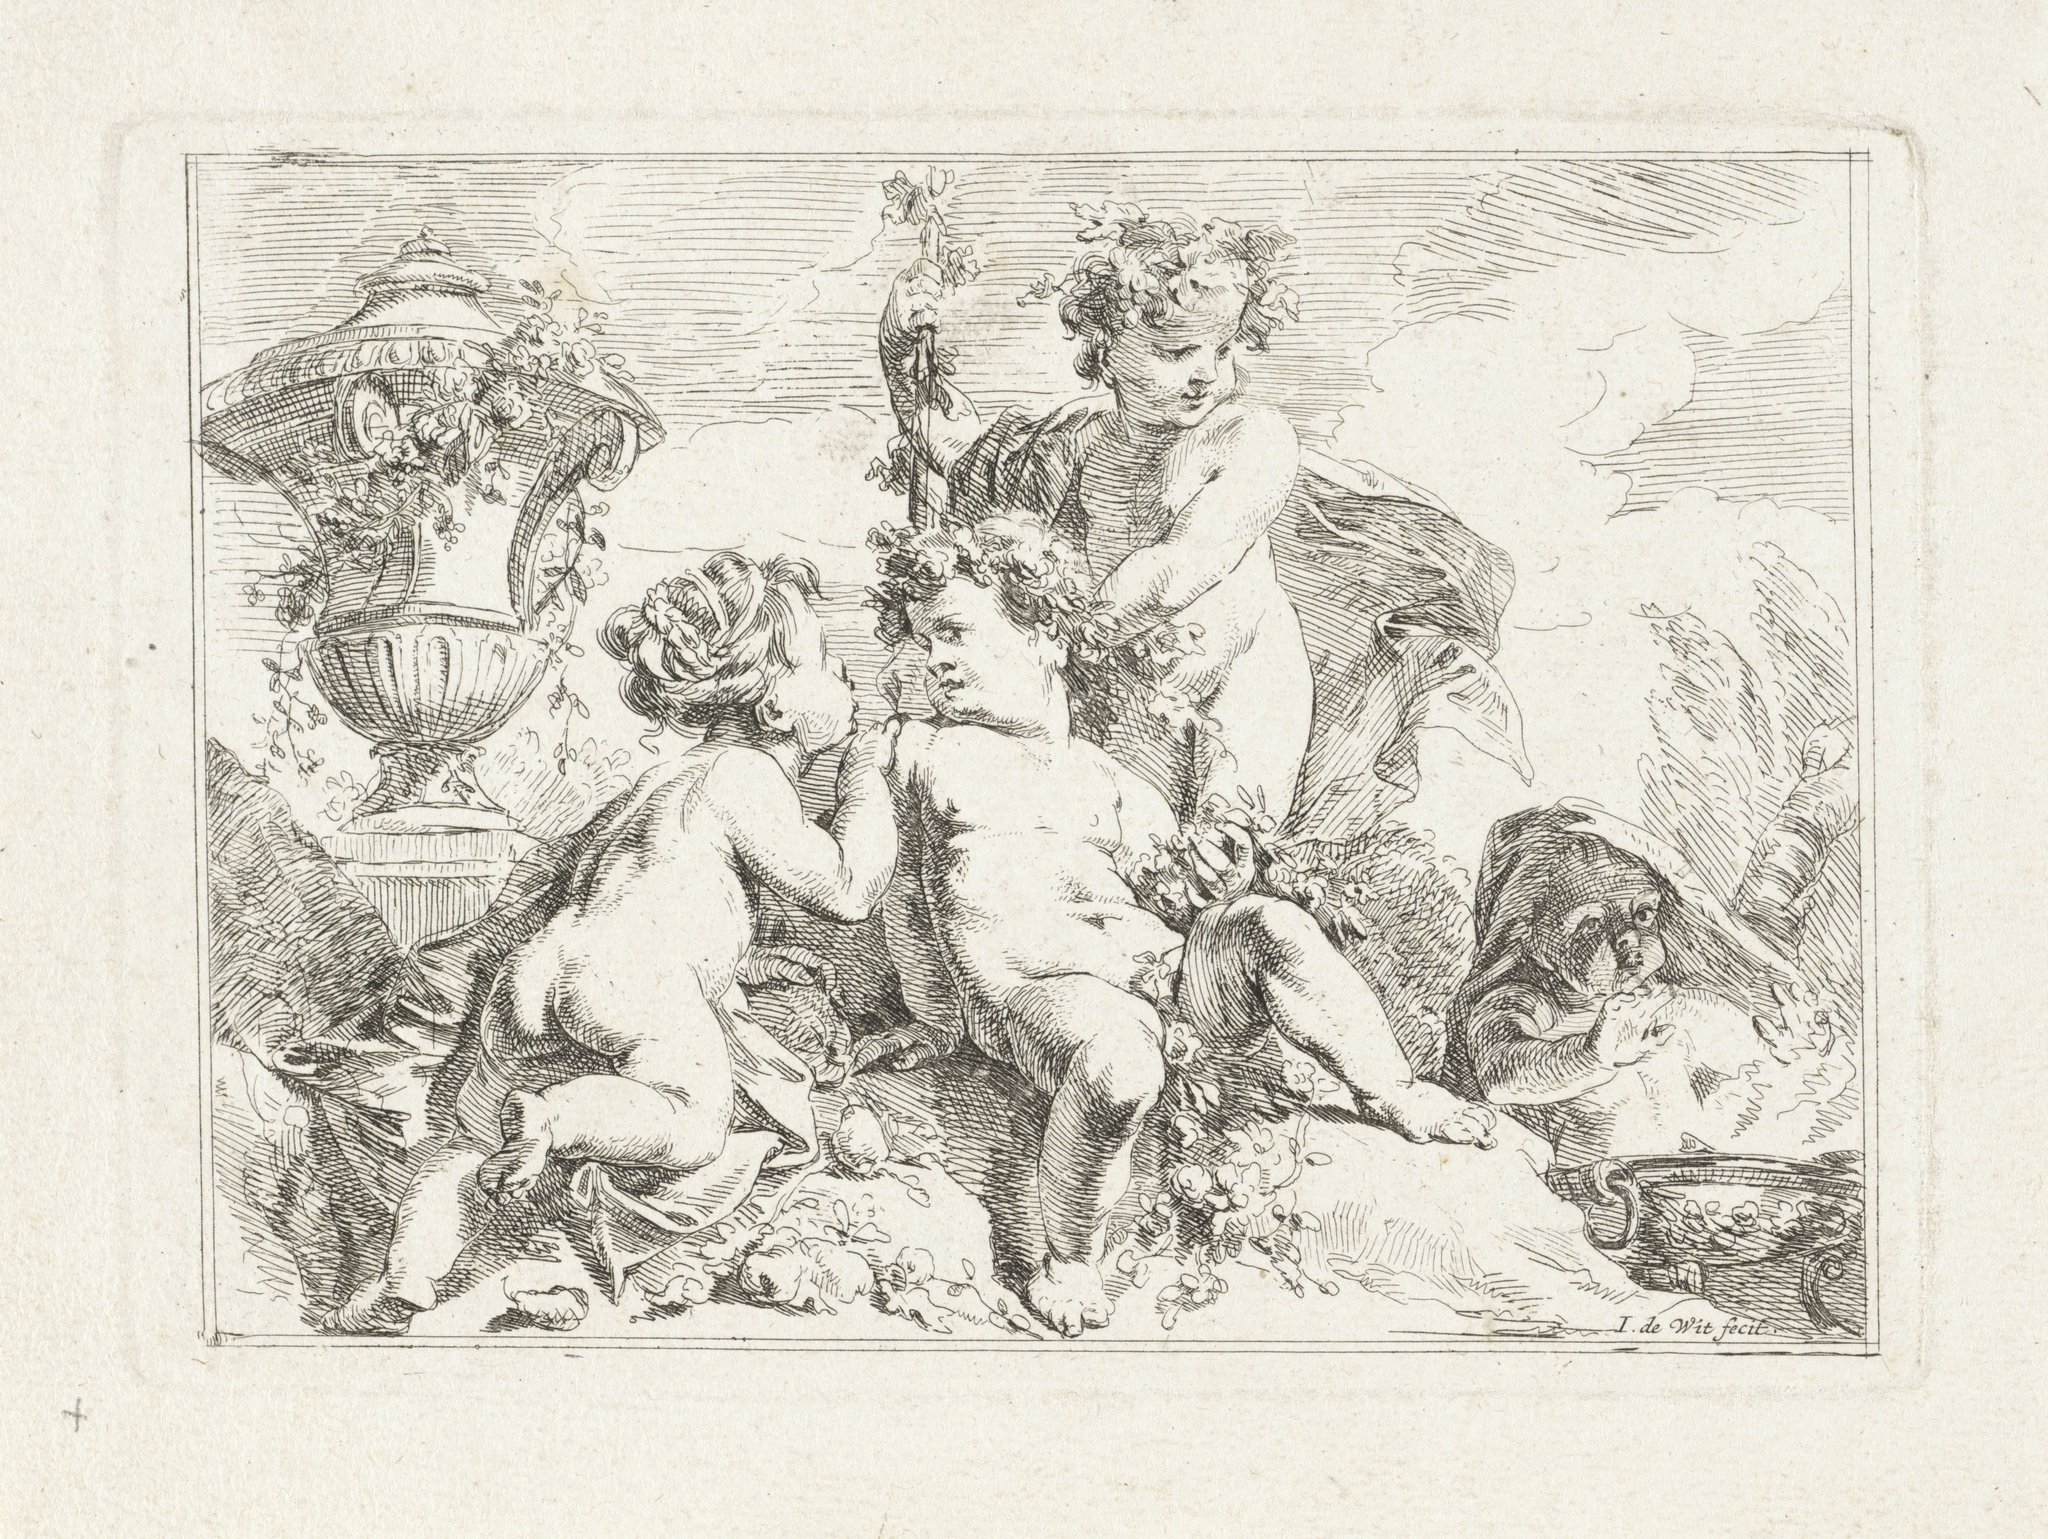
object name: print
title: Vier naakte kinderfiguren bij een tuinvaas (winter)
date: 1705-1754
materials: paper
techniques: etching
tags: winter, 'hyems'; 'inverno' (ripa) (+ allegorical or symbolical representation of seasons and months), warming oneself at a fire (or hearth, stove, fire-pan, brazier), child (+ nude human being), garden vase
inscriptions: collector's mark: Lugt 2228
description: Vier naakte kinderfiguren in een landschap, met guirlandes. Een van hen heeft druiventrossen en -bladeren om het hoofd en een ander warmt zich aan een komfoor.